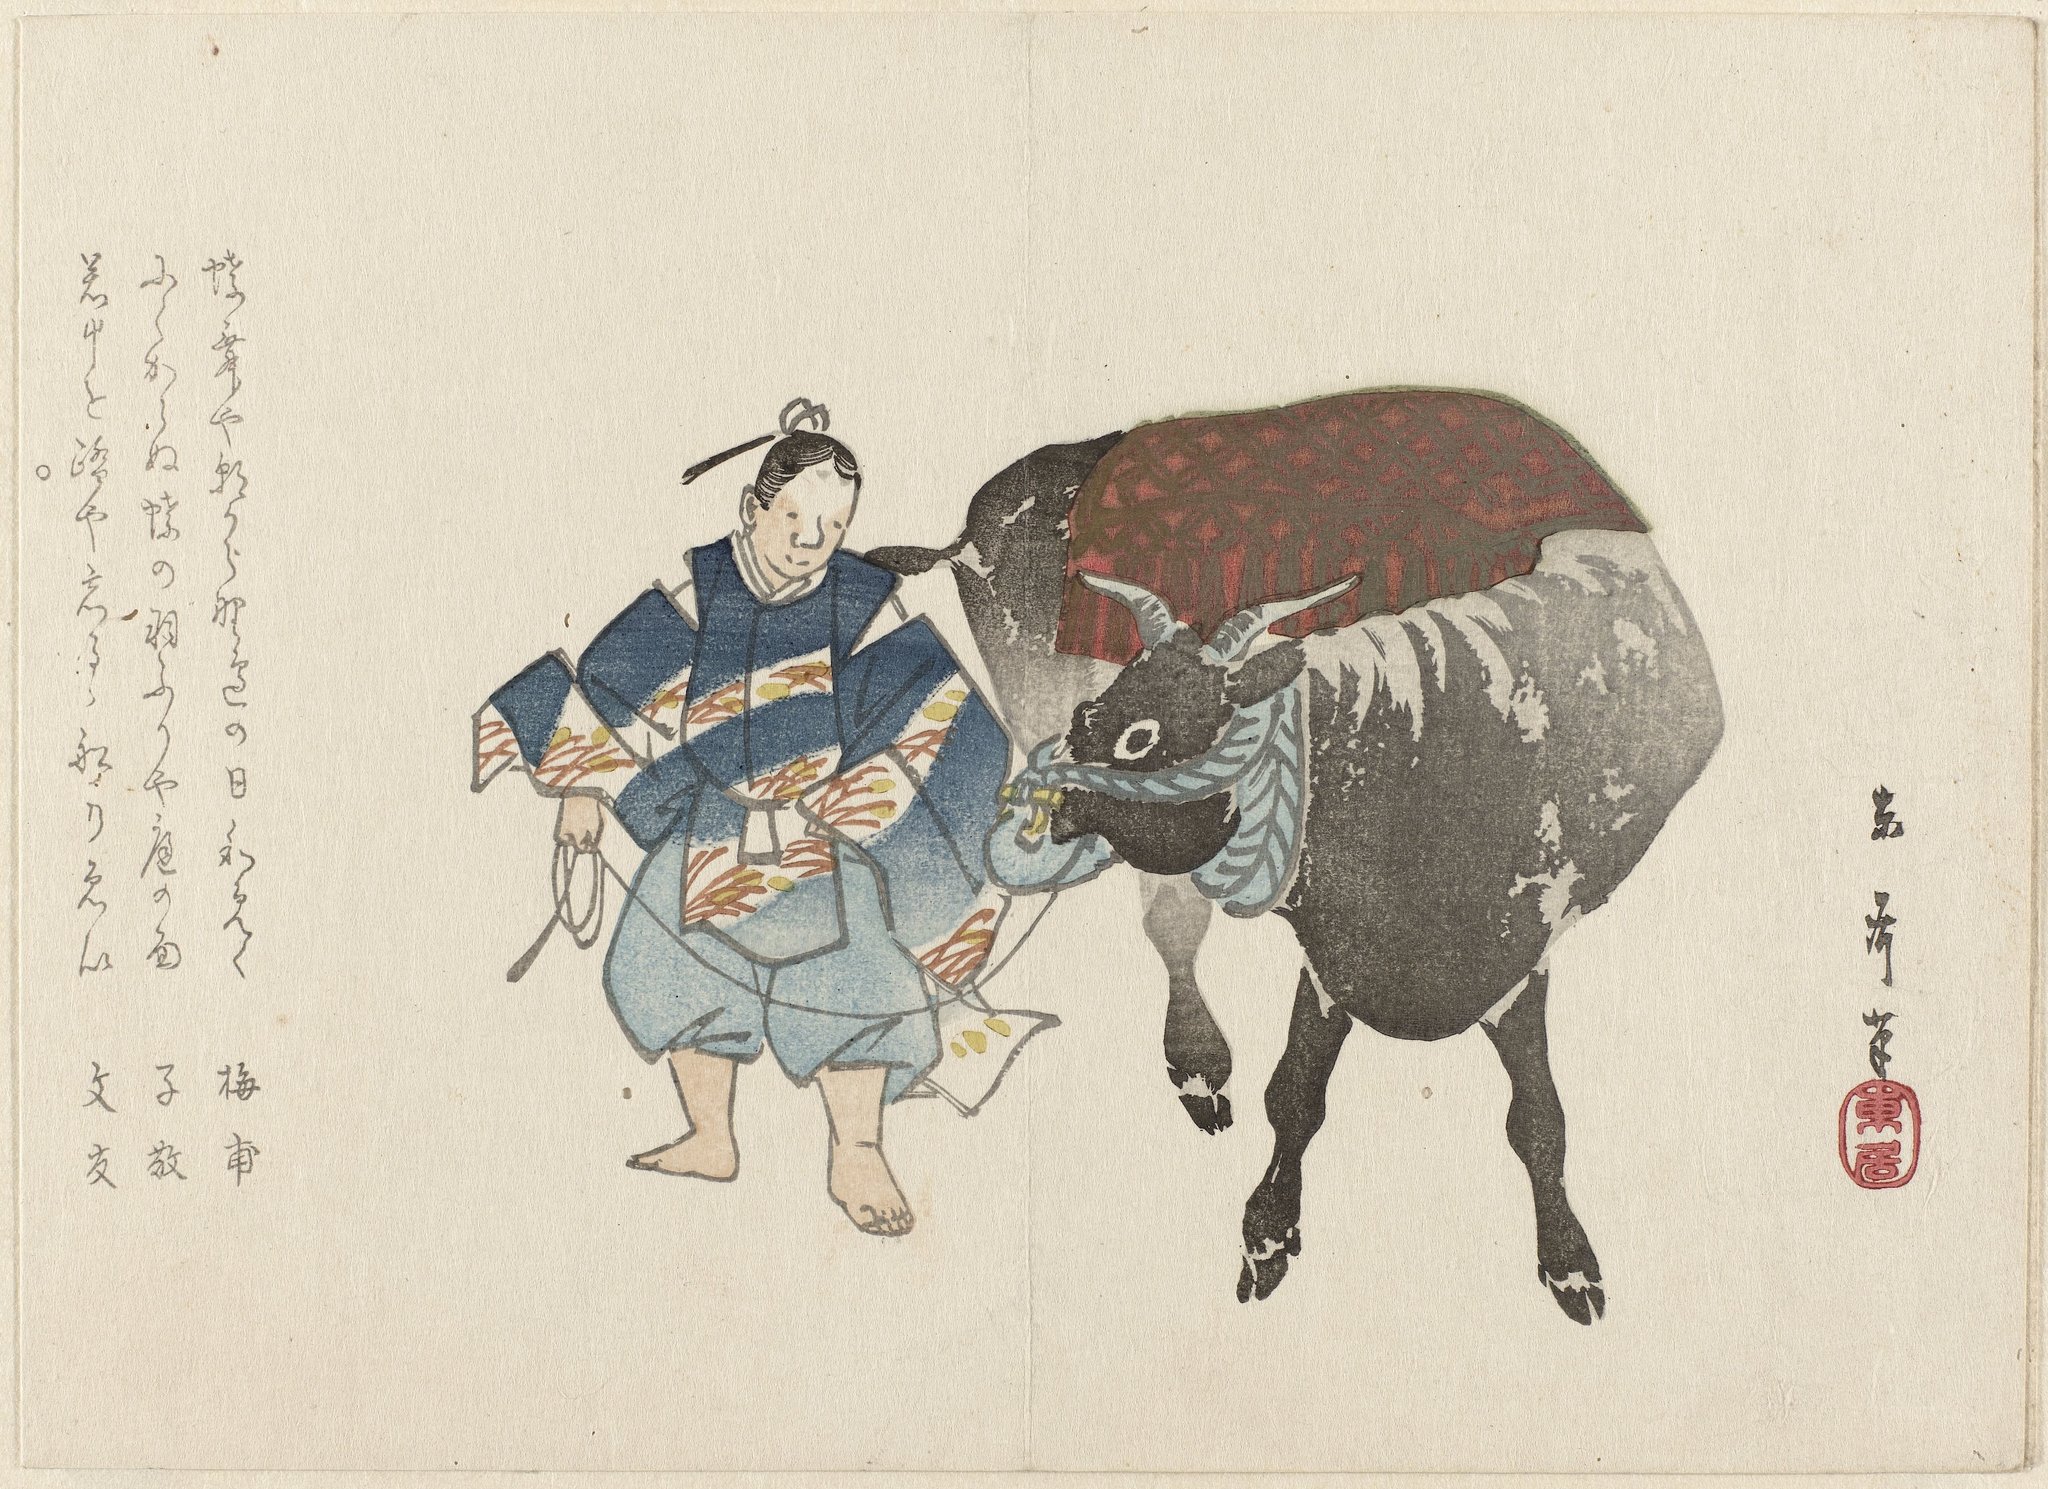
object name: surimono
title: Jonge man met os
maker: tôkyo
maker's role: print maker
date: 1850-1890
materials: paper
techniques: woodcut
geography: japan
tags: ox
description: Een surimono is een luxe uitgevoerde prent waarop beeld met één of meerdere gedichten gecombineerd is. Bij het drukken van een surimono werd vaak gebruik gemaakt van dikker papier, blinddruk en metaal pigmenten, zoals koper- en zilverpoeder. De prenten werden vaak in opdracht van dichters gemaakt en als exclusief geschenk aan vrienden en relaties gegeven.